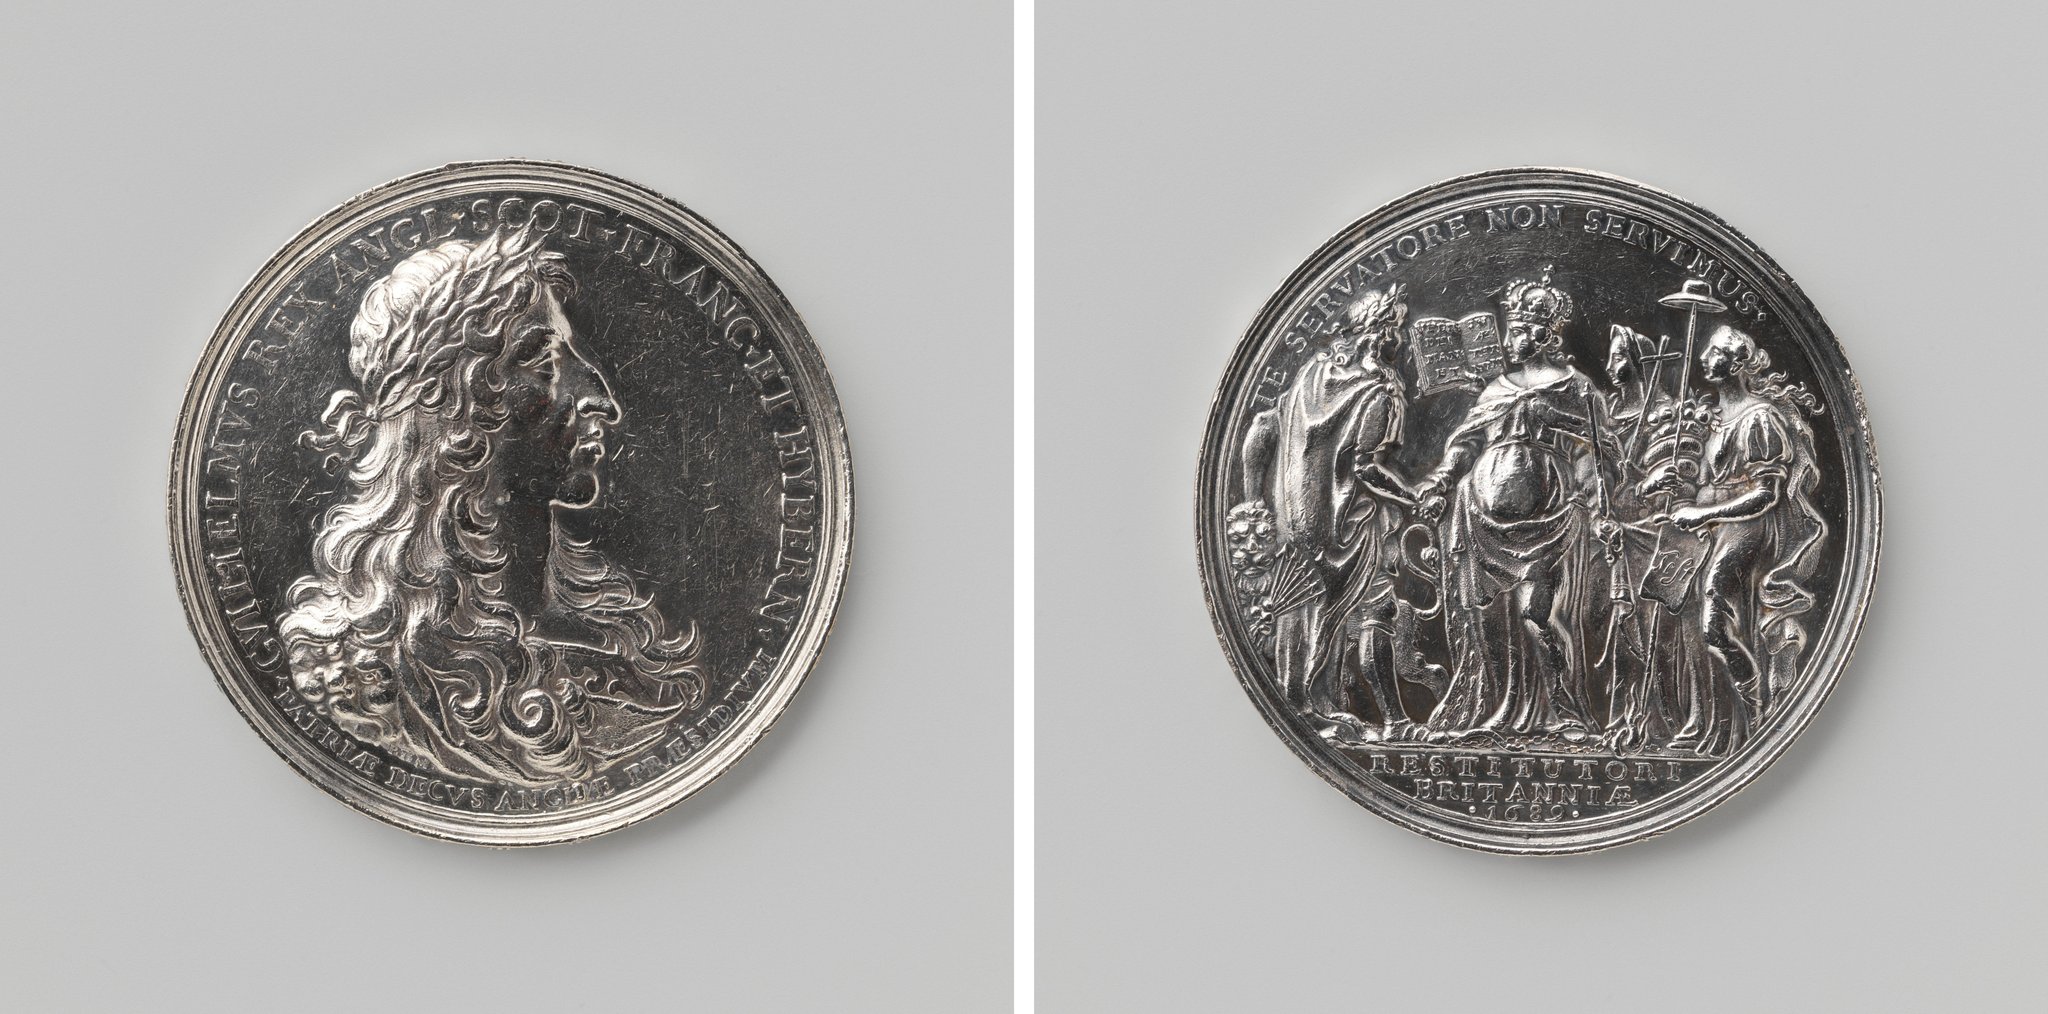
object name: history medal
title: Uitvoering van de Toleration Act en kroning van Willem III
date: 1689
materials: silver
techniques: striking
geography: nuremberg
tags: william iii (prince of orange and king of england, scotland, and ireland)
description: Zilveren penning. Voorzijde: borststuk man met lauwerkrans binnen omschrift. Keerzijde: nieuwe koning met lauwerkrans geeft Britannie met kroon en scepter een hand in aanwezigheid van Godsdienst met kruis en open bijbel en Vrijheid met hoed op speer en hoorn van overvloed binnen omschrift; randschrift